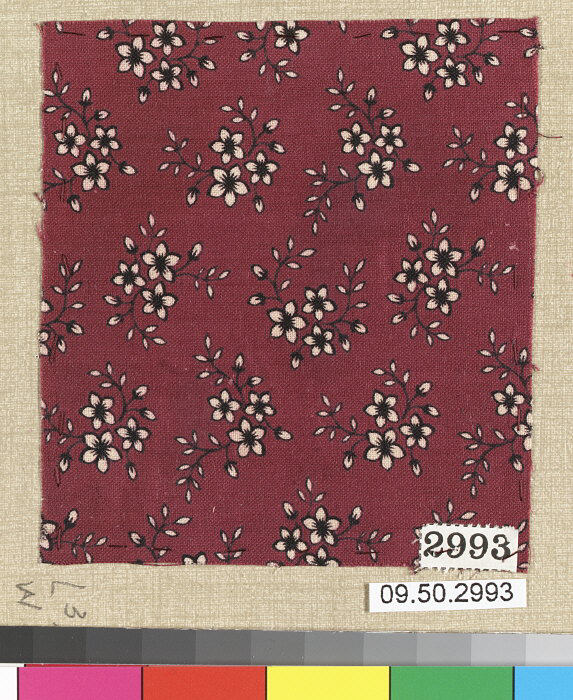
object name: piece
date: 1801-1900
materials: cotton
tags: flowers,leaves